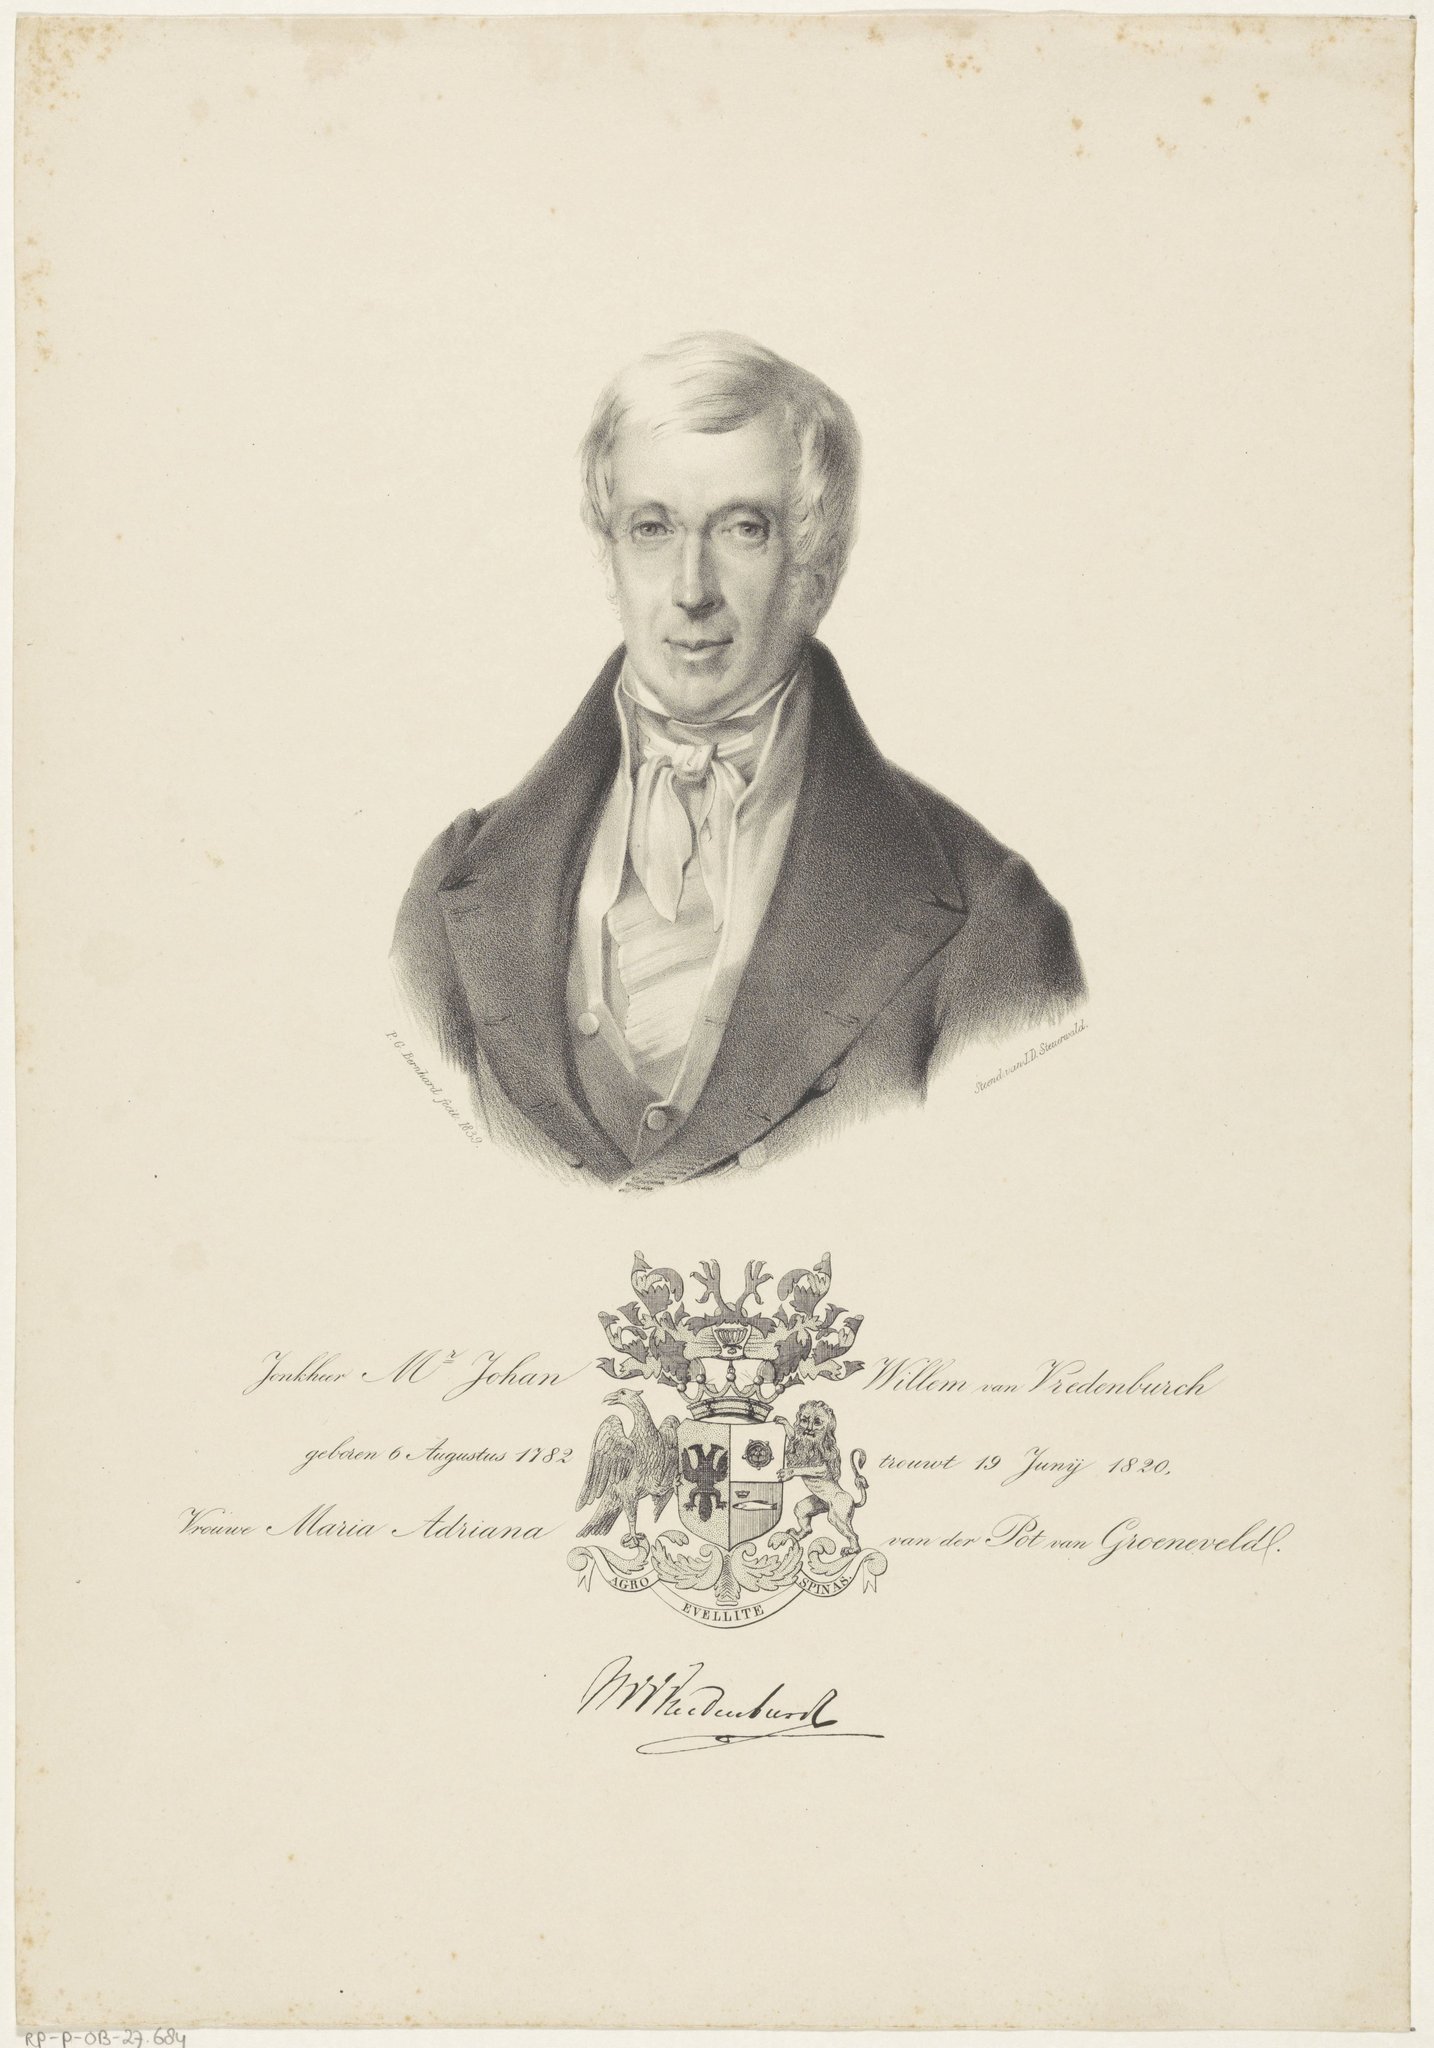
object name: print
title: Portret van Johan Willem van Vredenburch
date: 1839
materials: paper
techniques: lithograph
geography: the hague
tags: jonkheer johan willem van vredenburch van groeneveld, historical persons, armorial bearing, heraldry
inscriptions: collector's mark: Lugt 2228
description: Onder het portret de naam, geboorte- trouw- en sterfdatum en het familiewapen van de geportretteerde. Daaronder de signatuur van de geportretteerde.